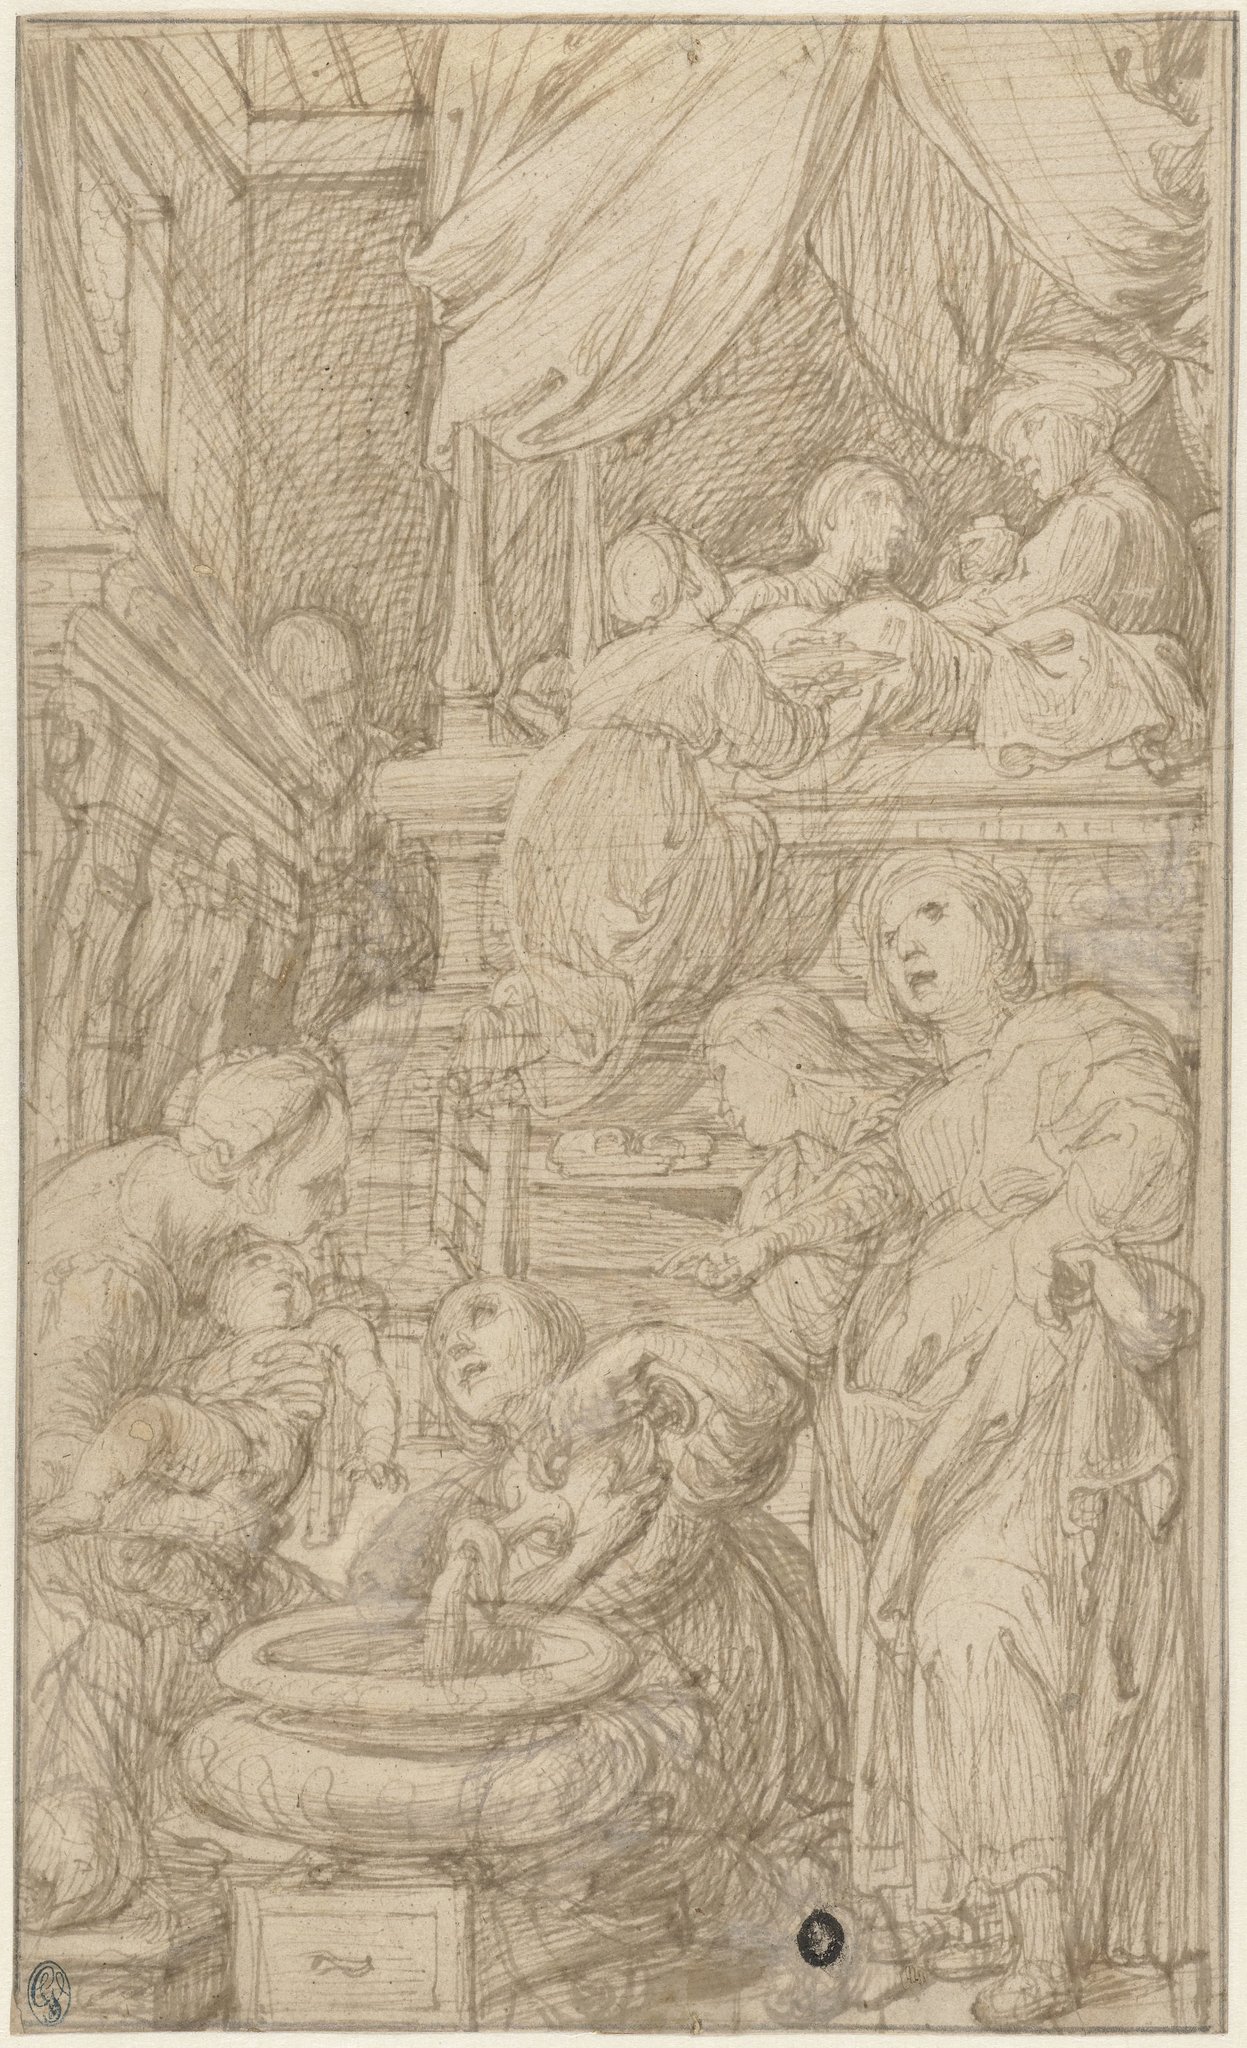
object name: drawing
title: Birth of the Virgin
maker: ferraù fenzoni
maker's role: draughtsman, painter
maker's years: 1562-1645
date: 1615-1625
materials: ink, paper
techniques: pen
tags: birth of mary